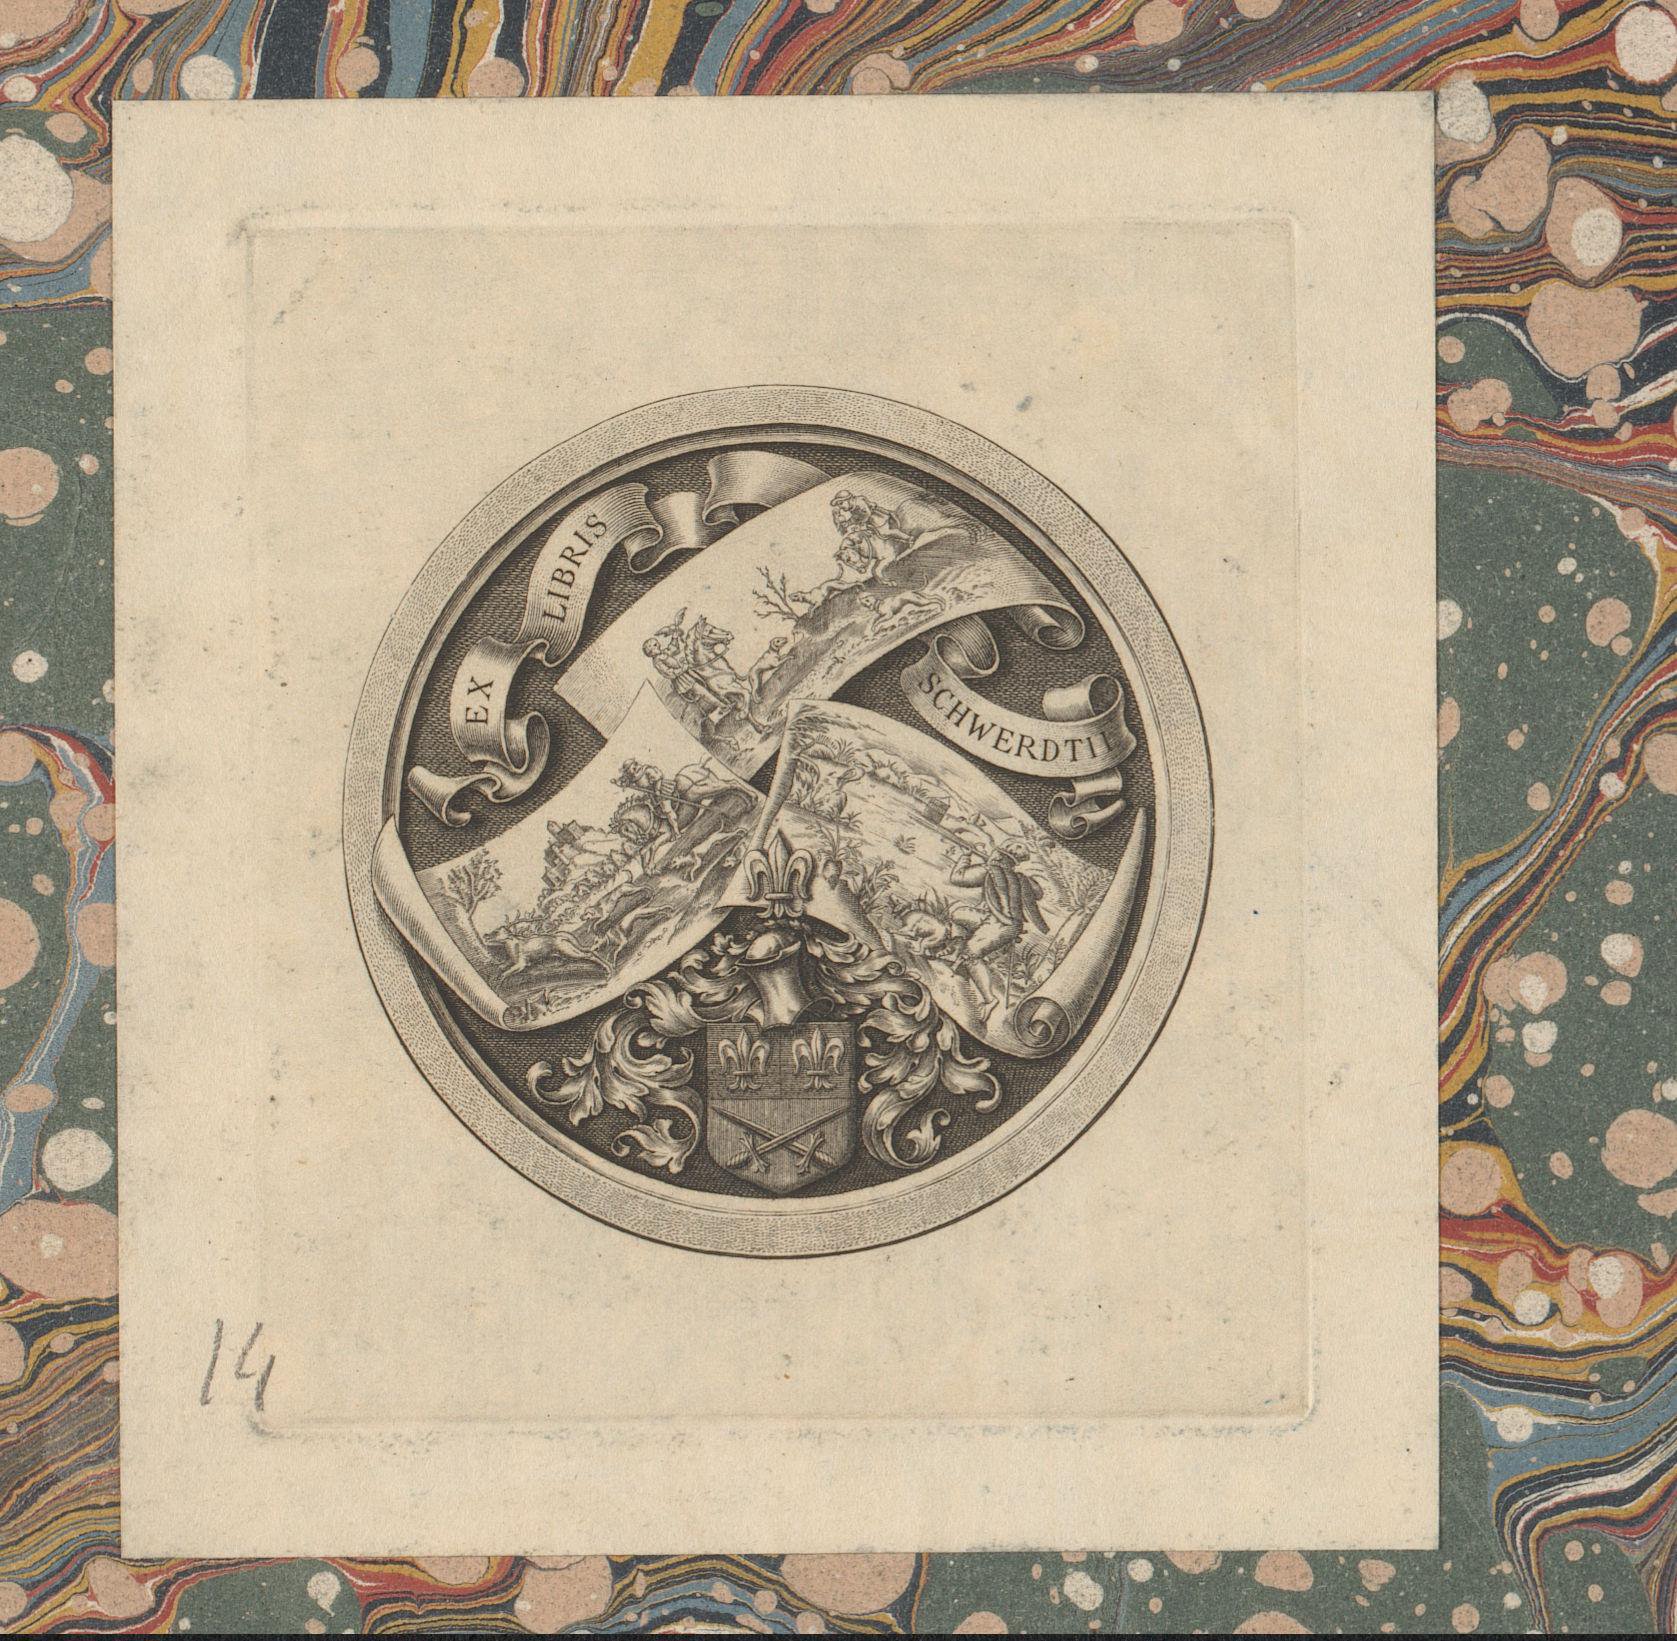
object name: print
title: Ex libris van Carl Franz Georg Richard Schwerdt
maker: Anonymous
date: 1882-1939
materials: paper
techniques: engraving, etching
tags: hunting, chase, armorial bearing, heraldry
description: Medaillon met drie voorstellingen van prenten met jachtscènes. Onderaan het wapenschild van Carl Franz Georg Richard Schwerdt. Bovenaan een banderol met tekst: Ex Libris Schwerdtii. Deze prent maakt deel uit van een album.